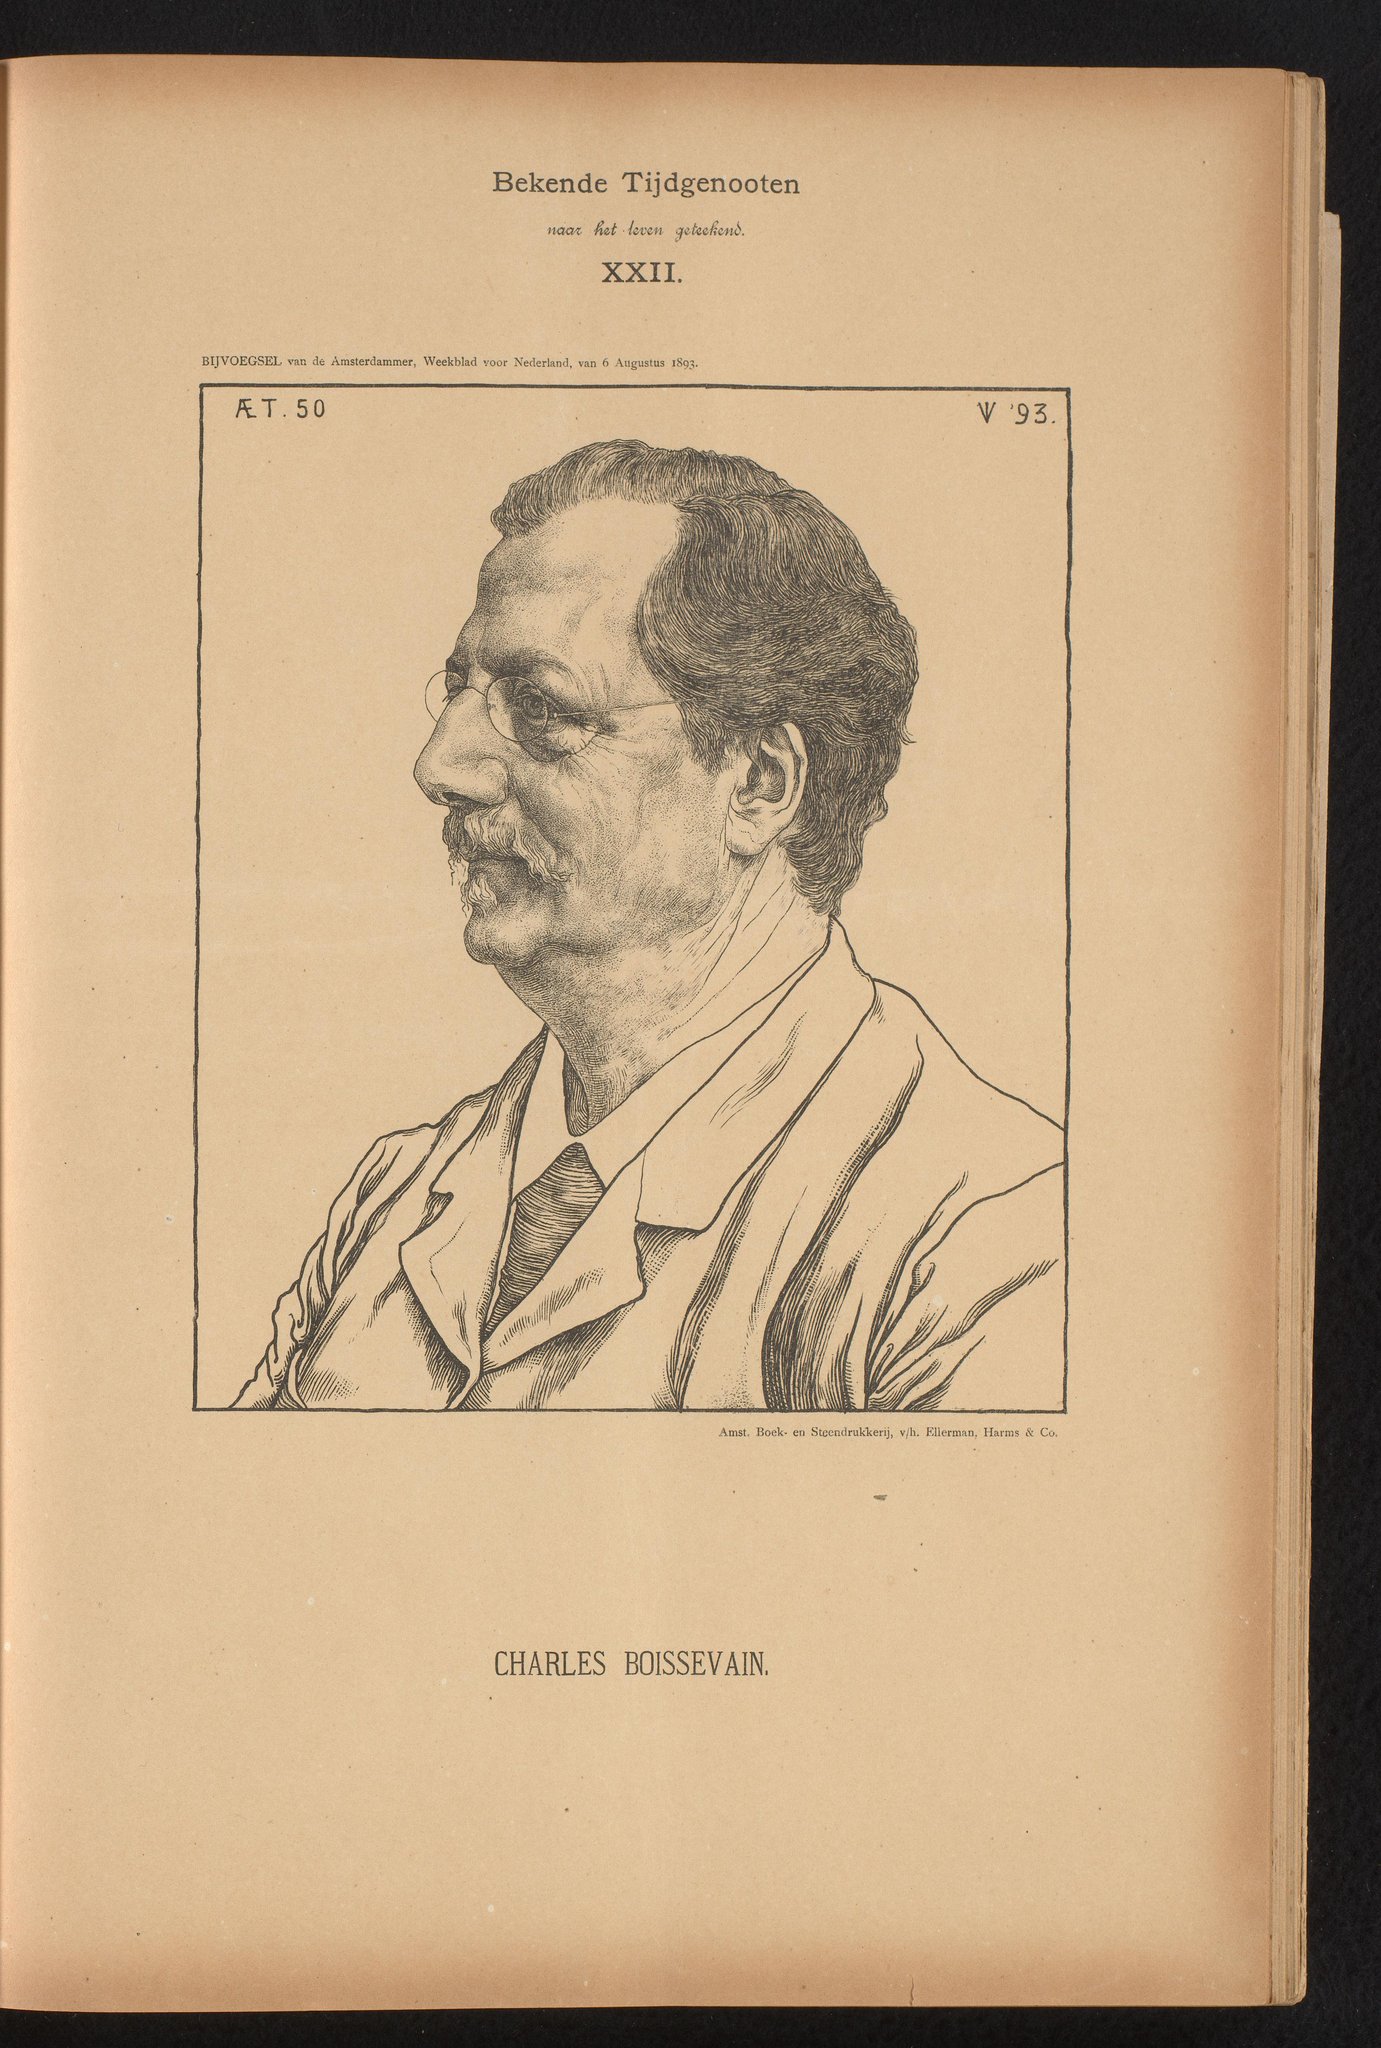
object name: print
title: Charles Boissevain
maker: jan veth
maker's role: designer, draughtsman, painter, print maker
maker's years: 1864-1925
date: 1893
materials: paper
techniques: lithograph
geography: netherlands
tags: charles boissevain, journalist, reporter, historical persons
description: Portret van de journalist Charles Boissevain, redacteur en eigenaar van het Algemeen Handelsblad. In de serie 'Bekende Tijdgenooten', nr. XXII.